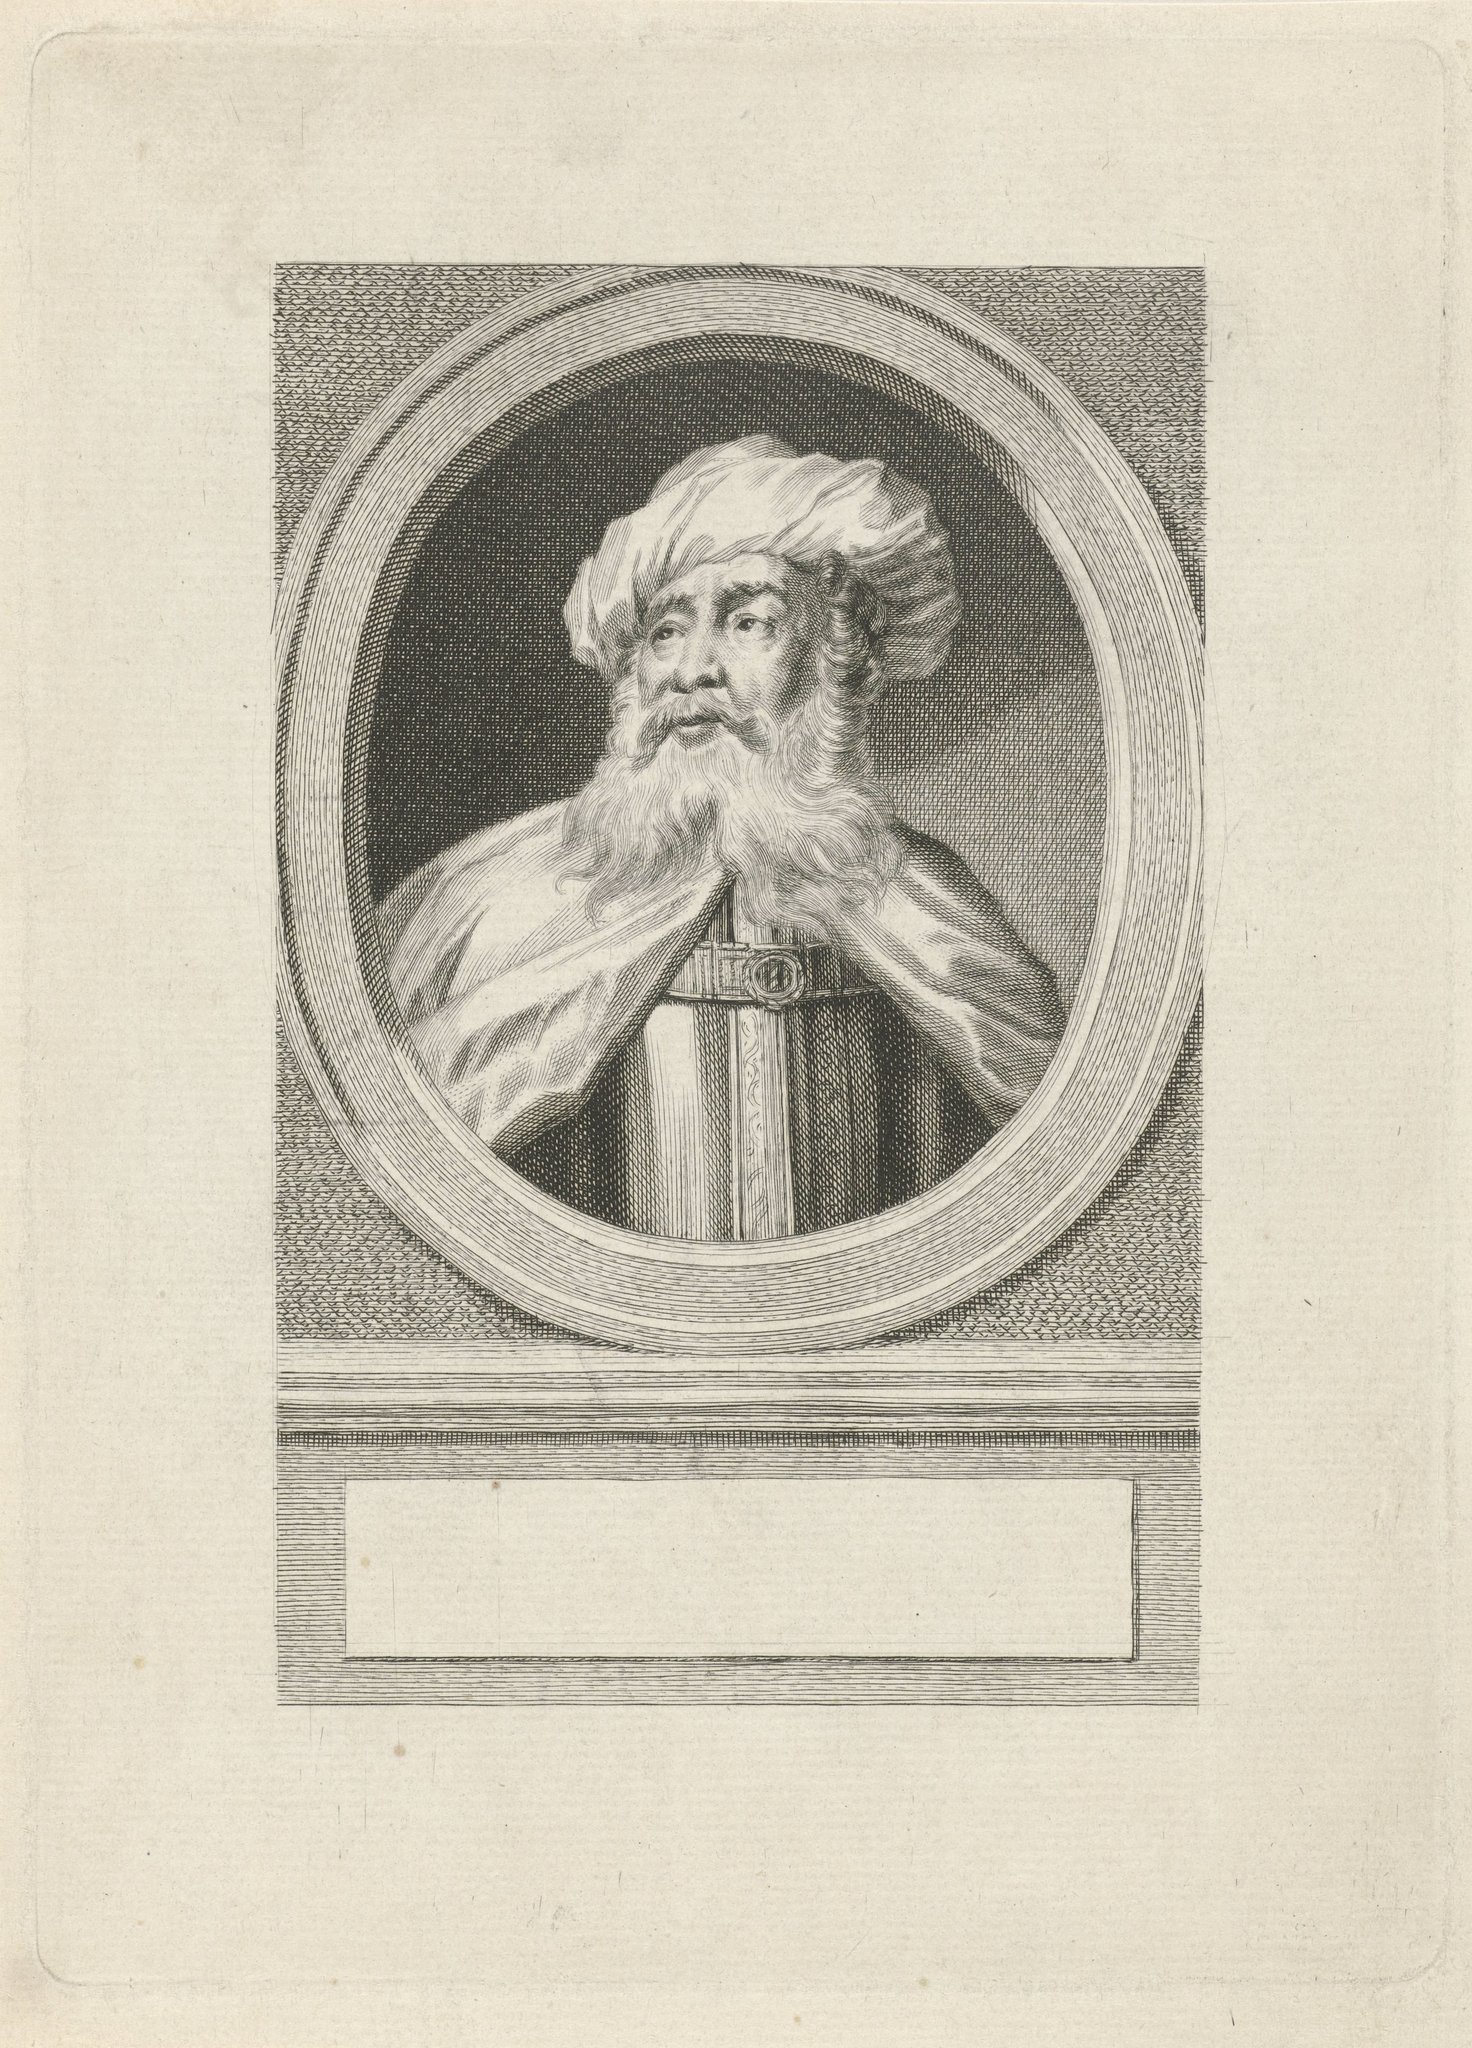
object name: print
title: Portret van Flavius Josephus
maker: jacob houbraken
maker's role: draughtsman, print maker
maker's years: 1698-1780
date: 1778-1780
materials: paper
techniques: engraving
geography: amsterdam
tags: rome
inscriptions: collector's mark: Lugt 2228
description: Proefdruk van de prent volgens Ver Huell gebruikt in: Johannes Nomsz, Mengelwerken. Amsterdam: erven D. Klippink, 1782.